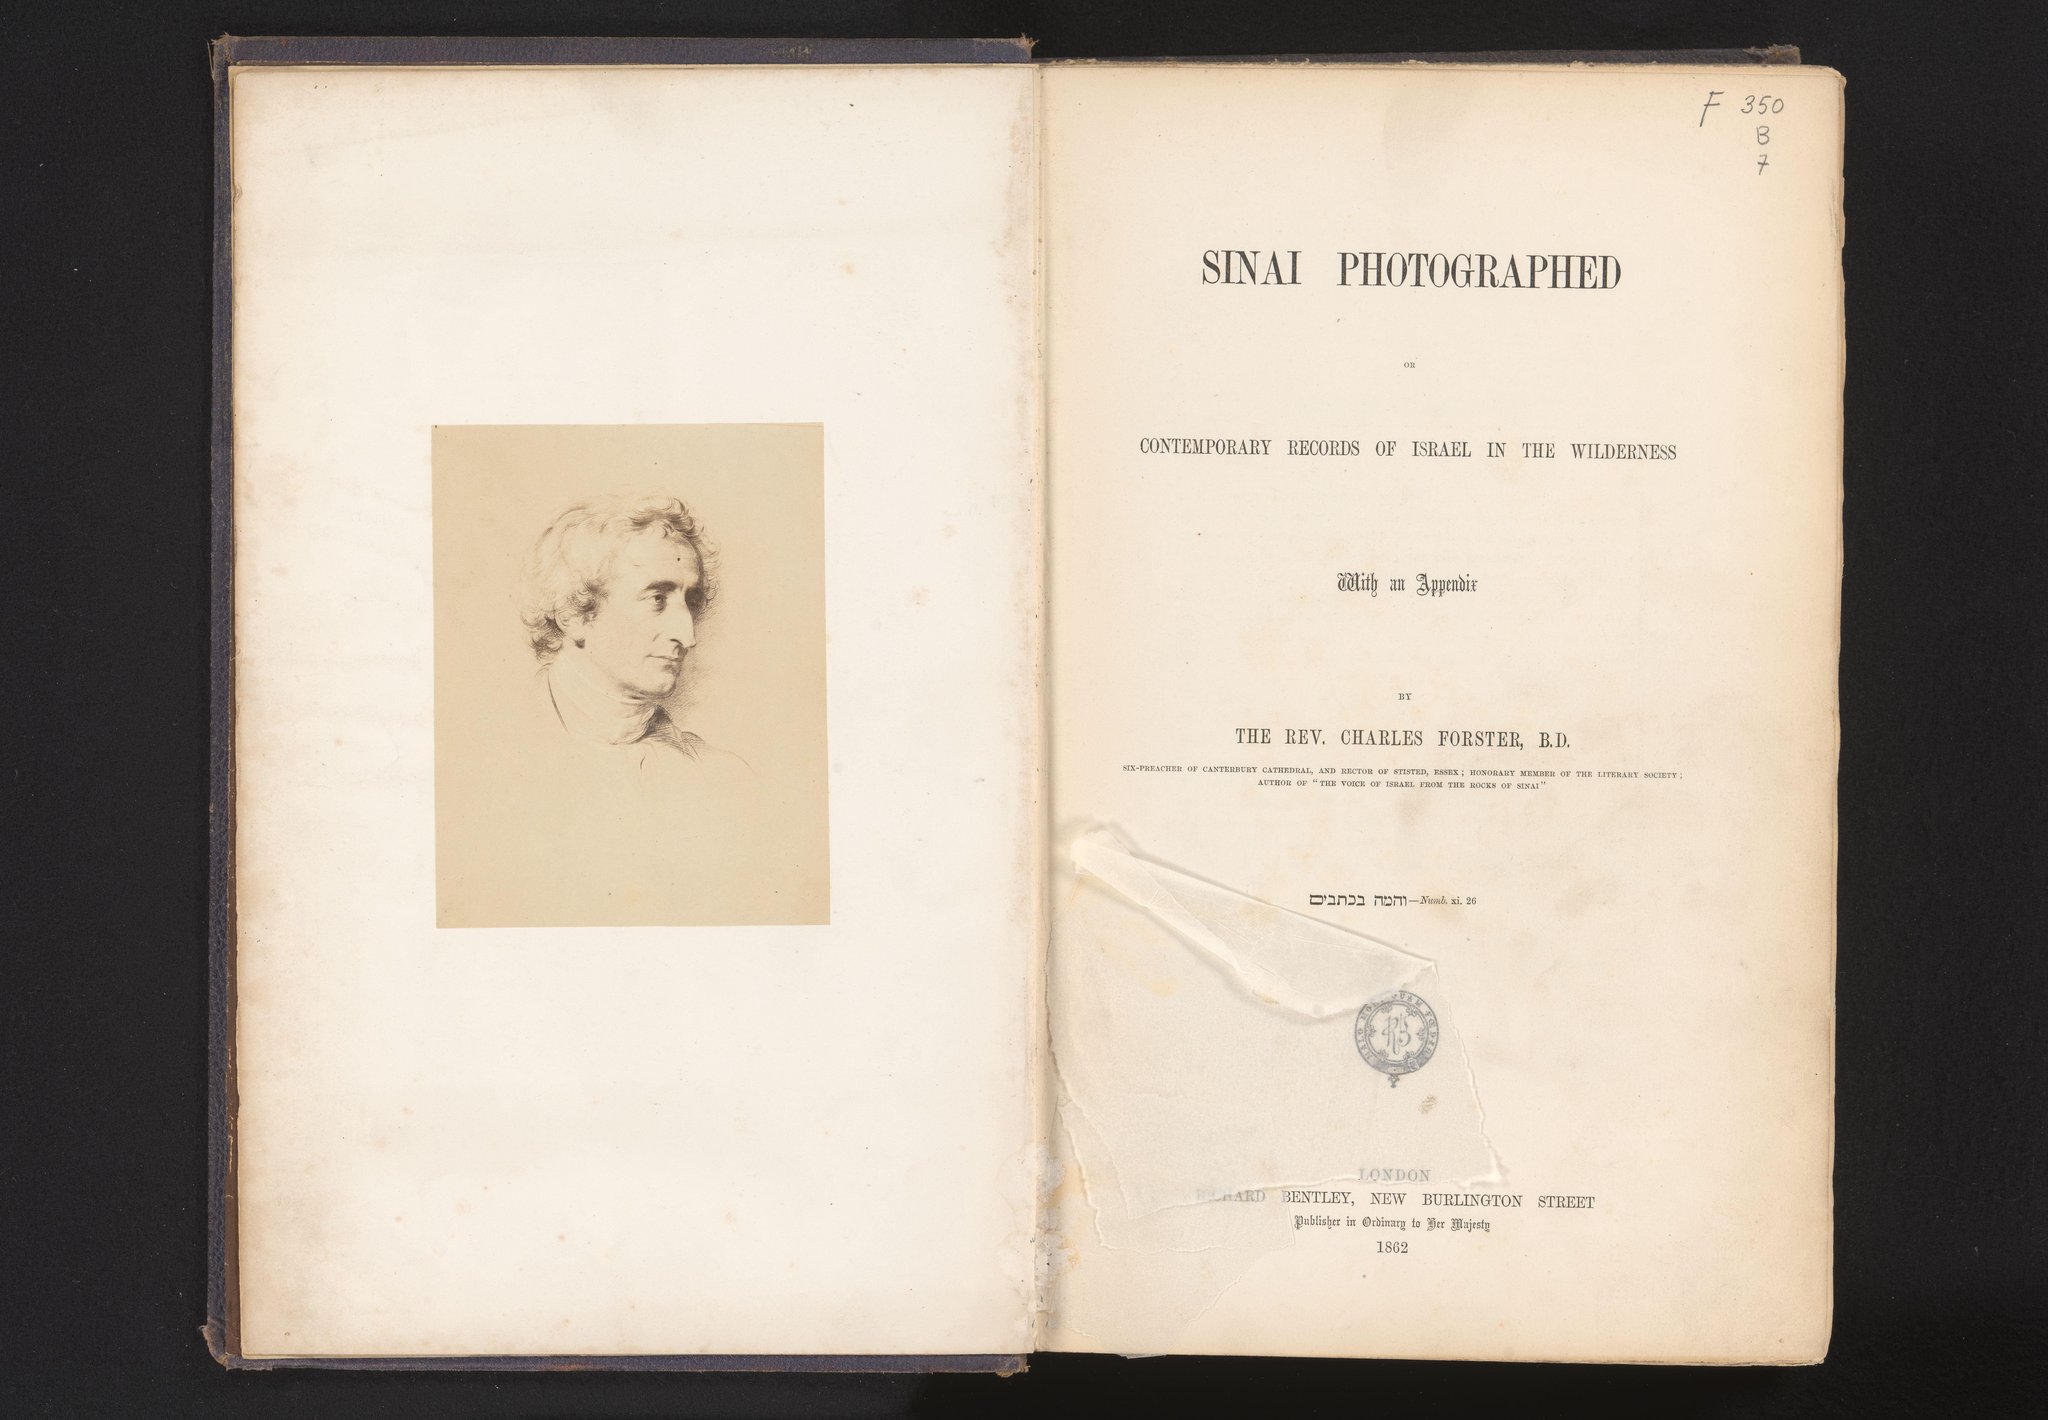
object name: book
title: Sinai photographed, or contemporary records of Israel in the wilderness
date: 1862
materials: cardboard, paper, textile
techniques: albumen print, letterpress printing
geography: london